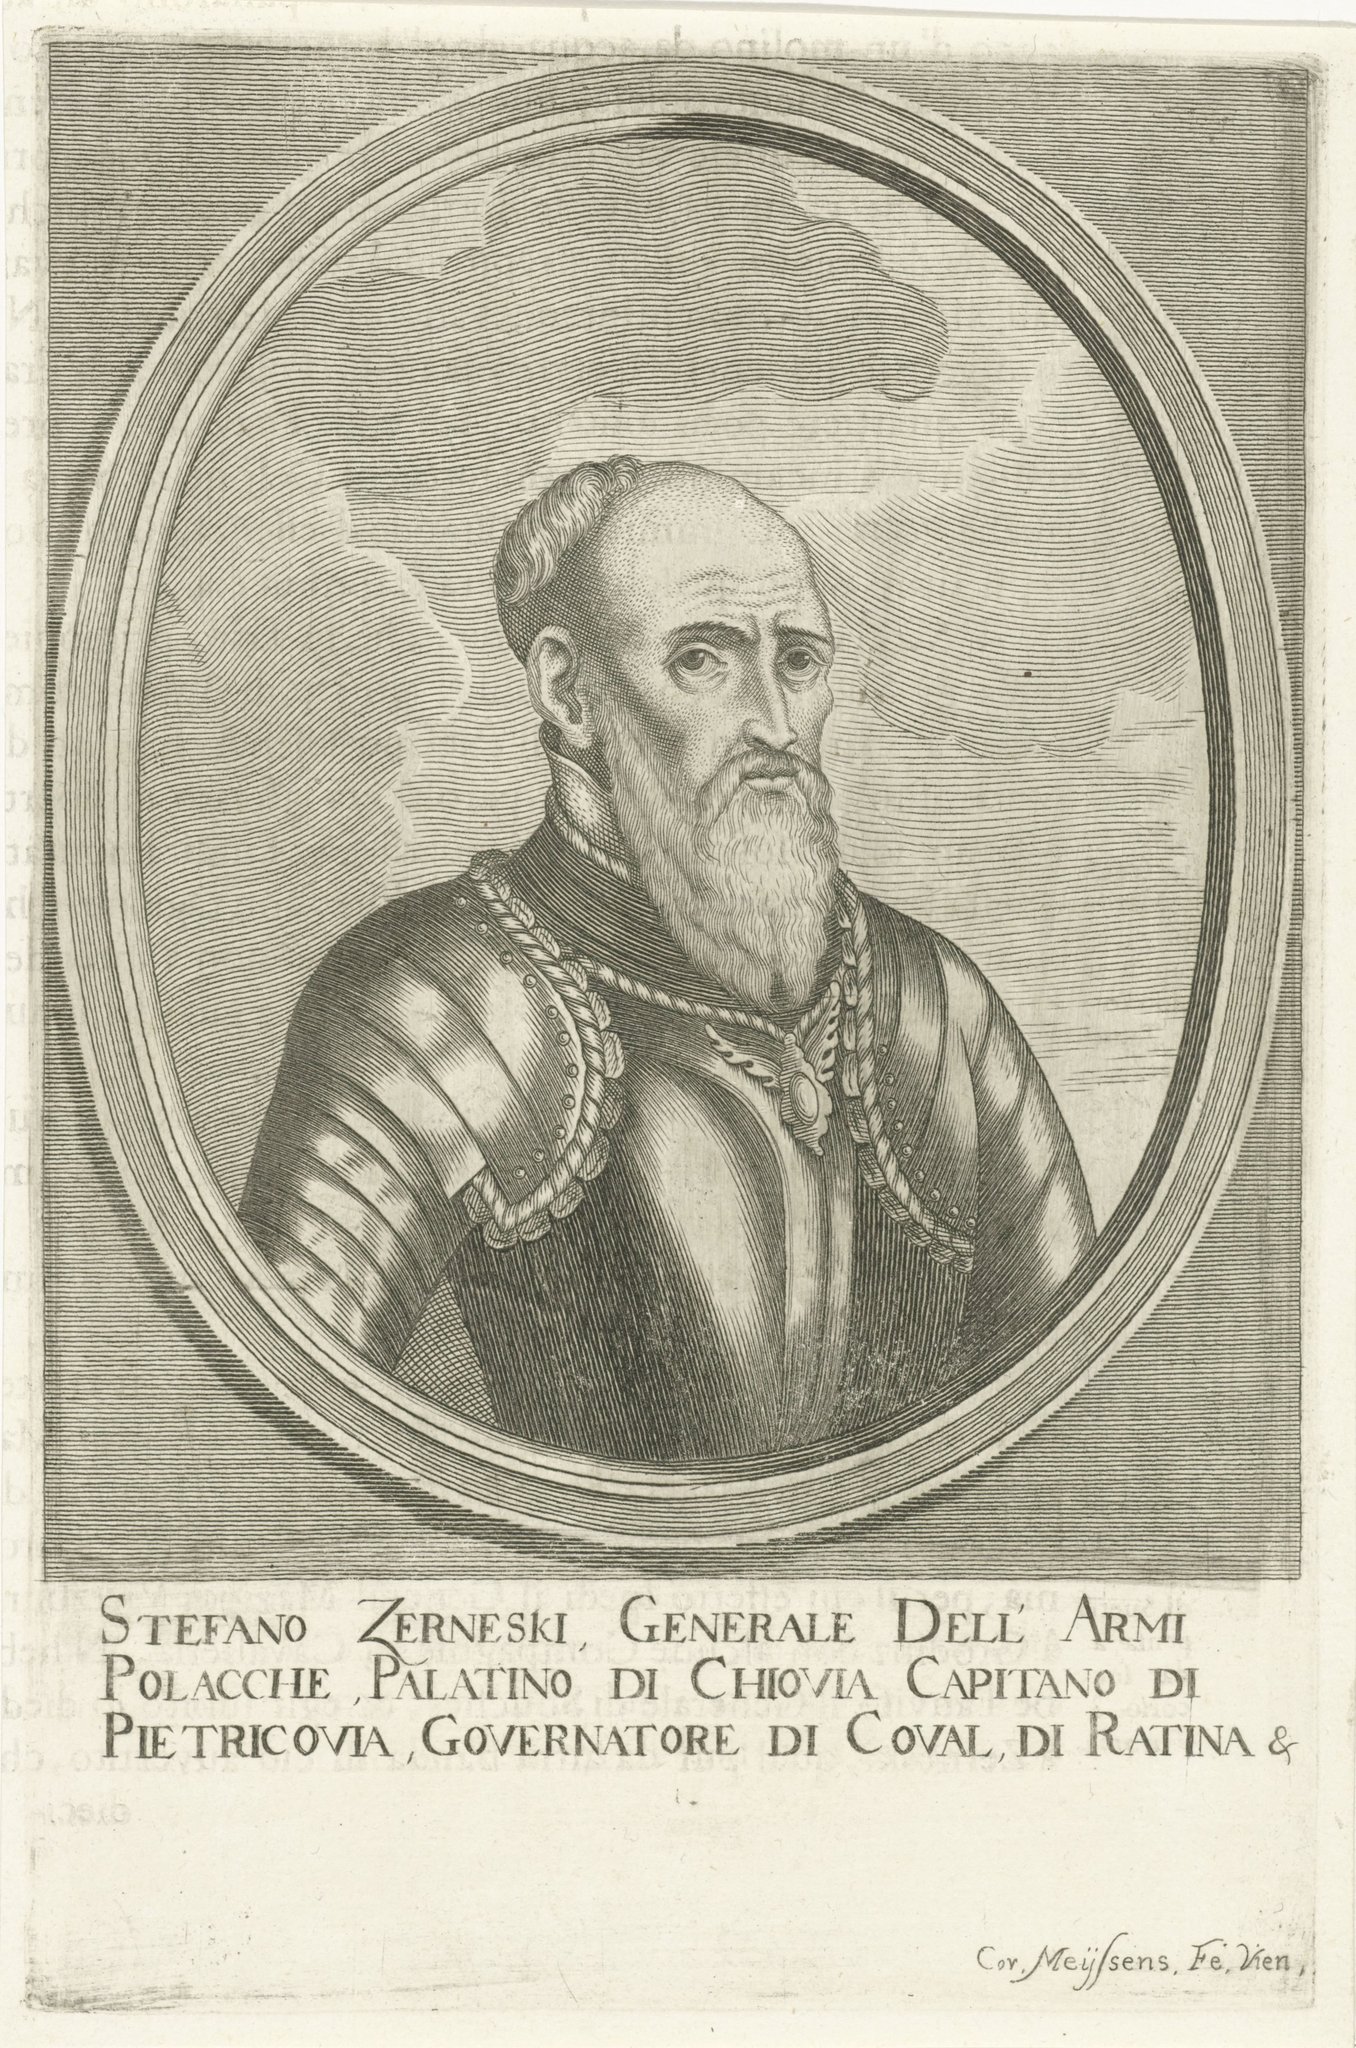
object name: print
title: Portret van Stefano Zerneski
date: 1670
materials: paper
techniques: engraving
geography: vienna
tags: stefano zerneski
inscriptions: collector's mark: Lugt 2228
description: Prent gebruikt in: Gualdo Priorato, Galeazzo. Historia di Leopoldo Cesare, (...). 3 dln. Wenen, Giovanni Battista Hacque, 1670-1674, dl. 1.